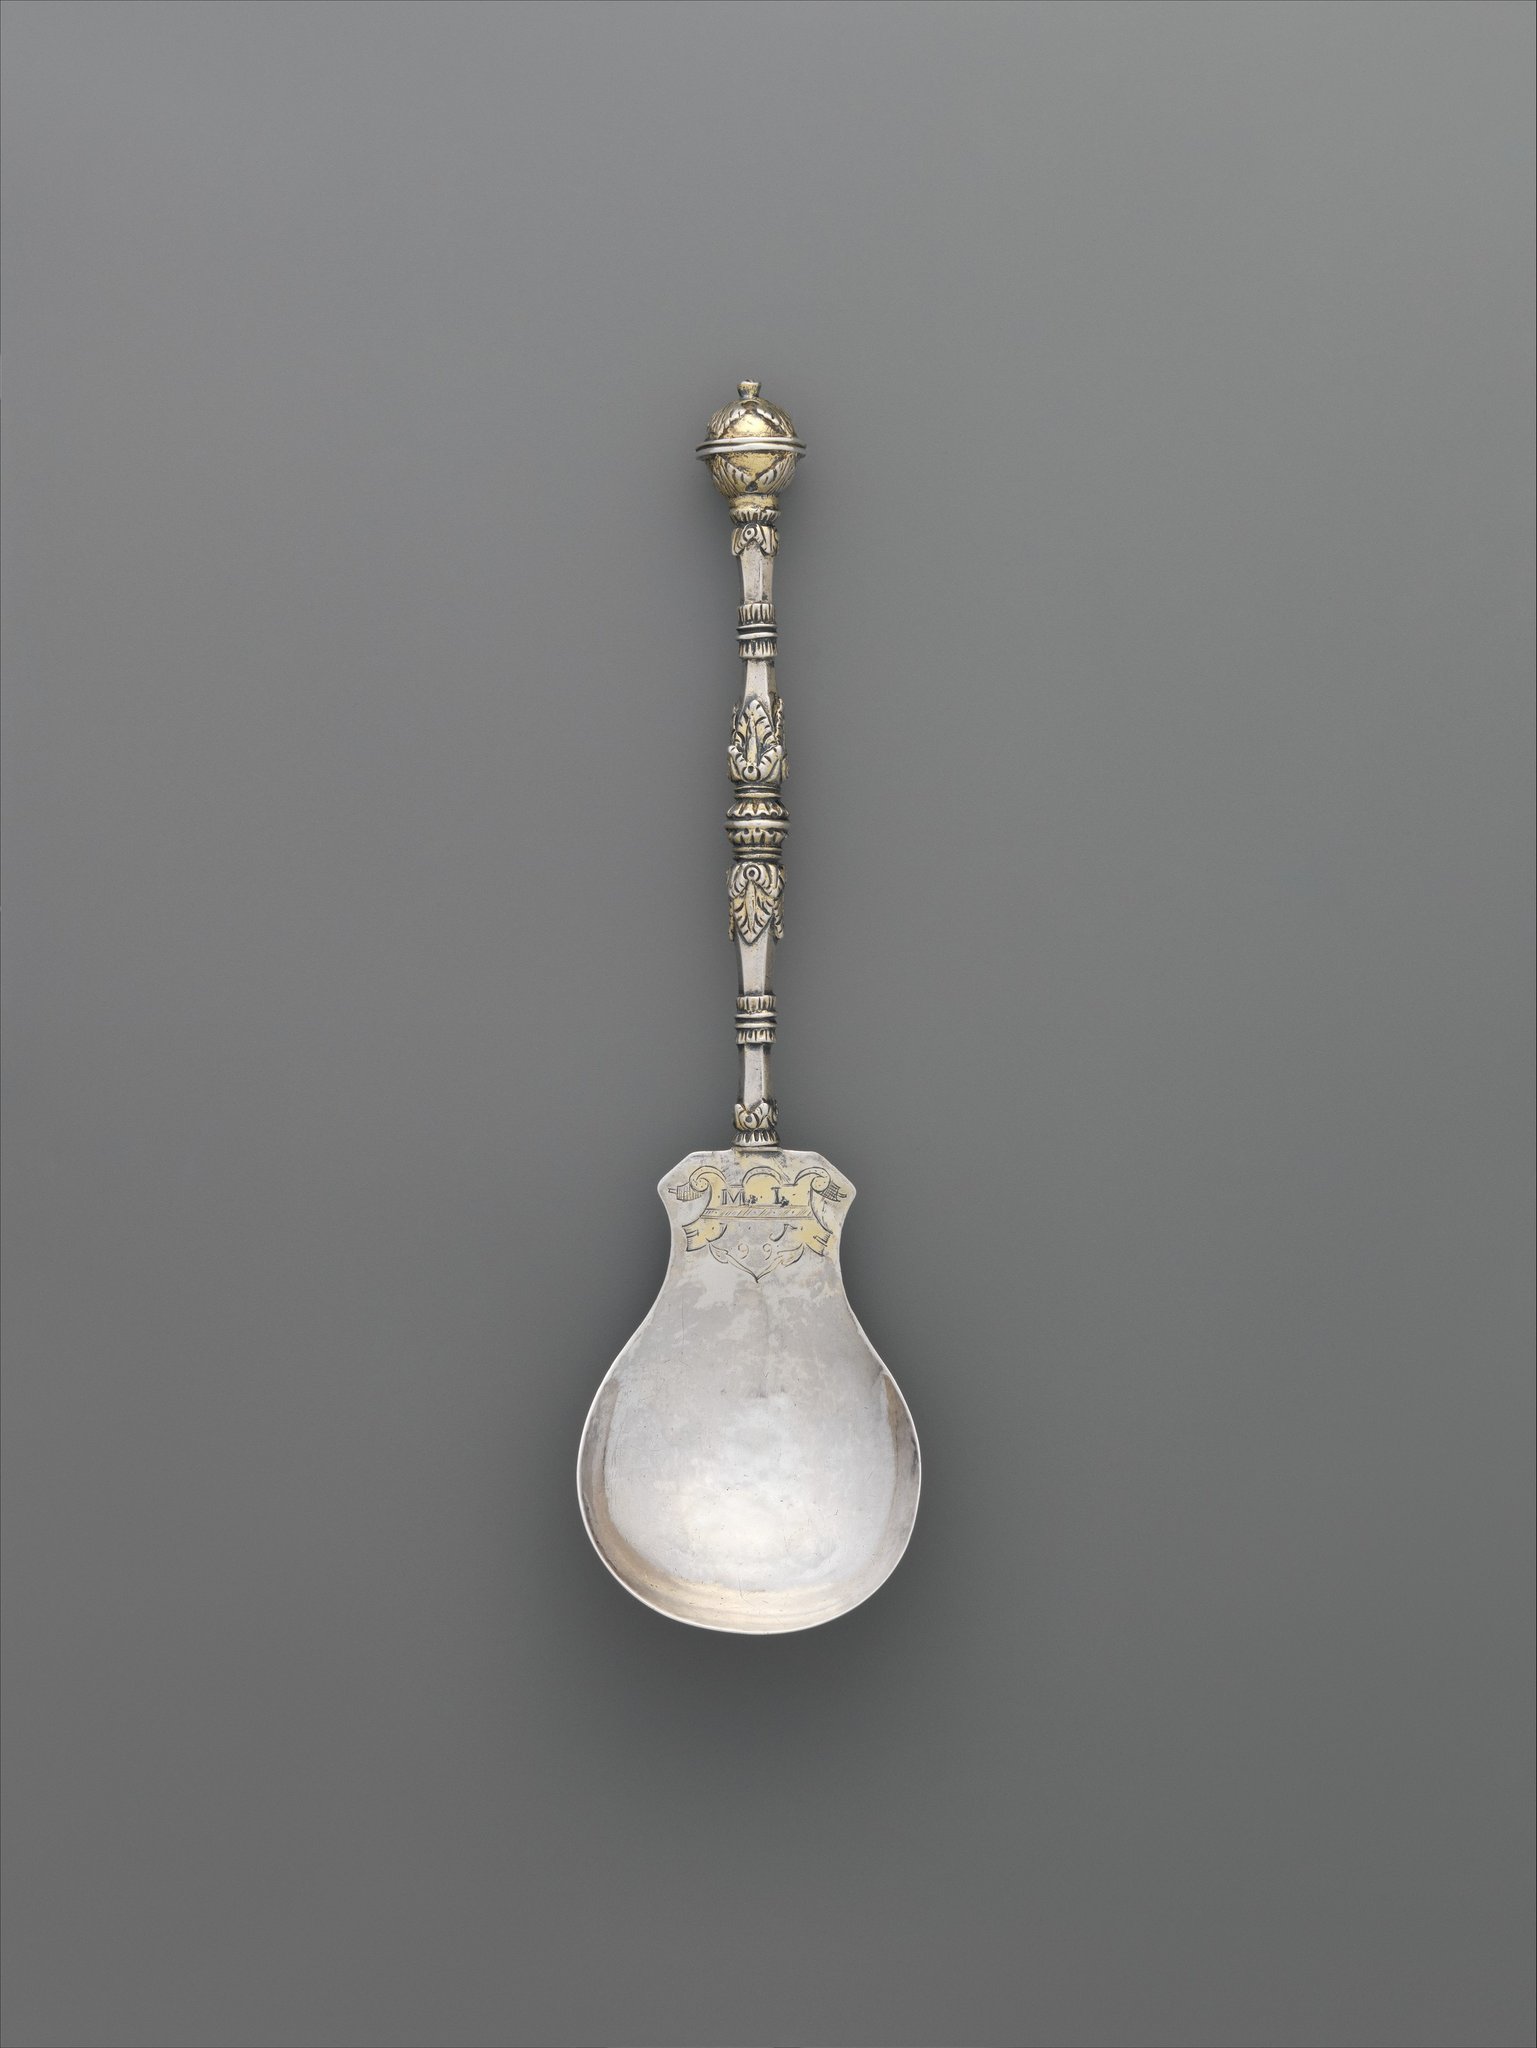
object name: spoon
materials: silver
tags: coat of arms